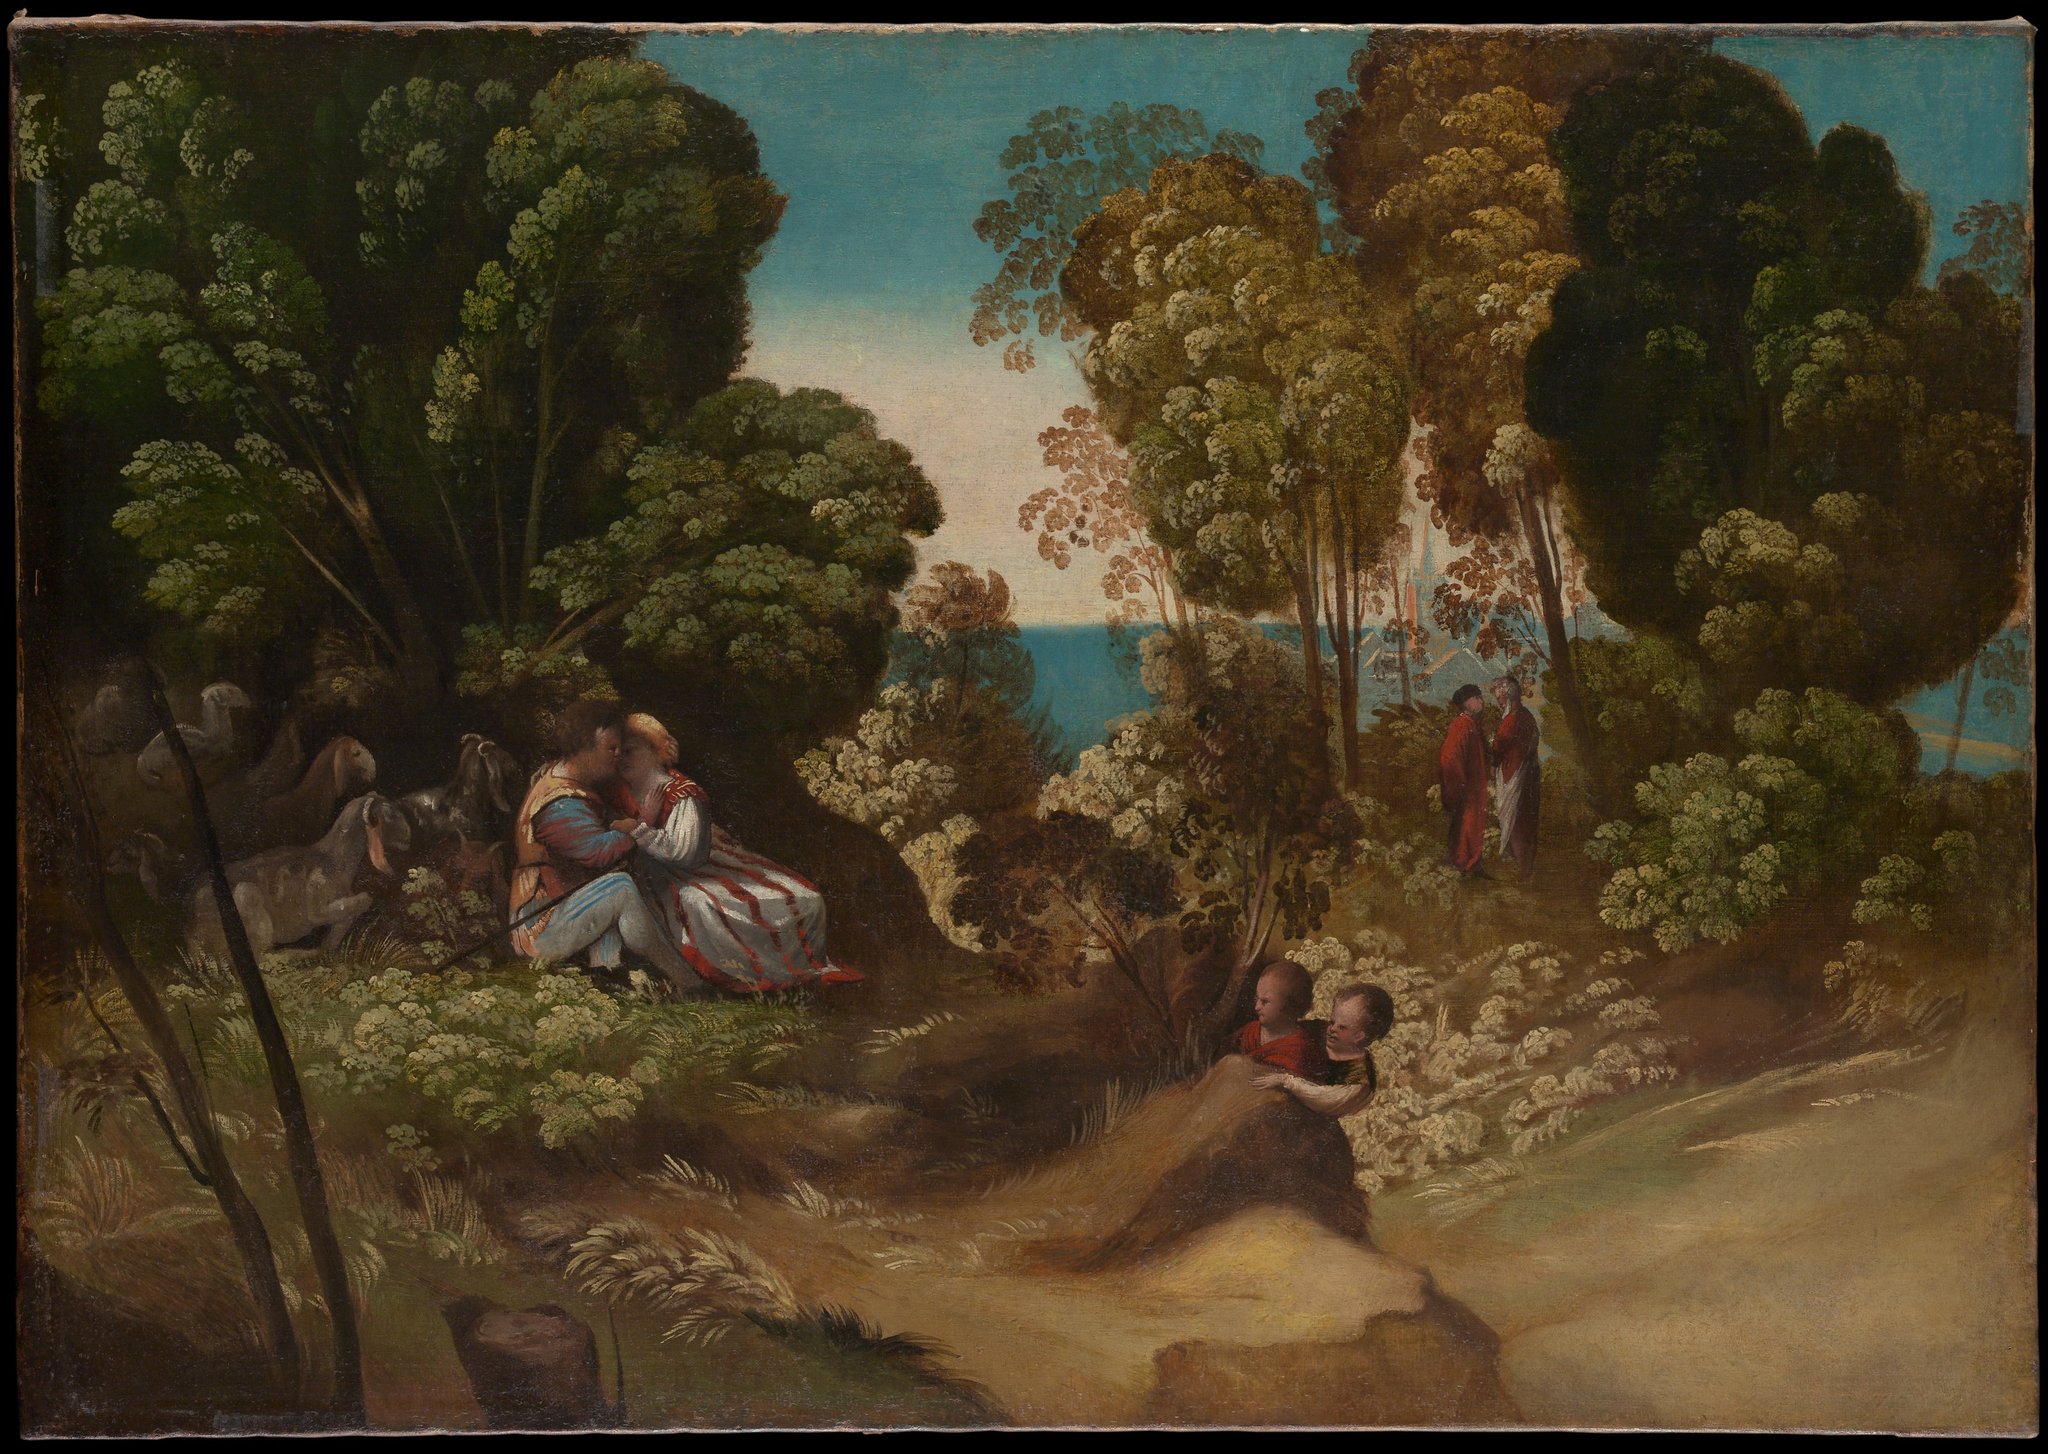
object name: painting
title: The Three Ages of Humans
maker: dosso dossi (giovanni de lutero)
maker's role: artist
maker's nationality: italian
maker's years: 1486-1542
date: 1512-1542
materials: canvas, oil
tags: boys,couples,men,women,sheep